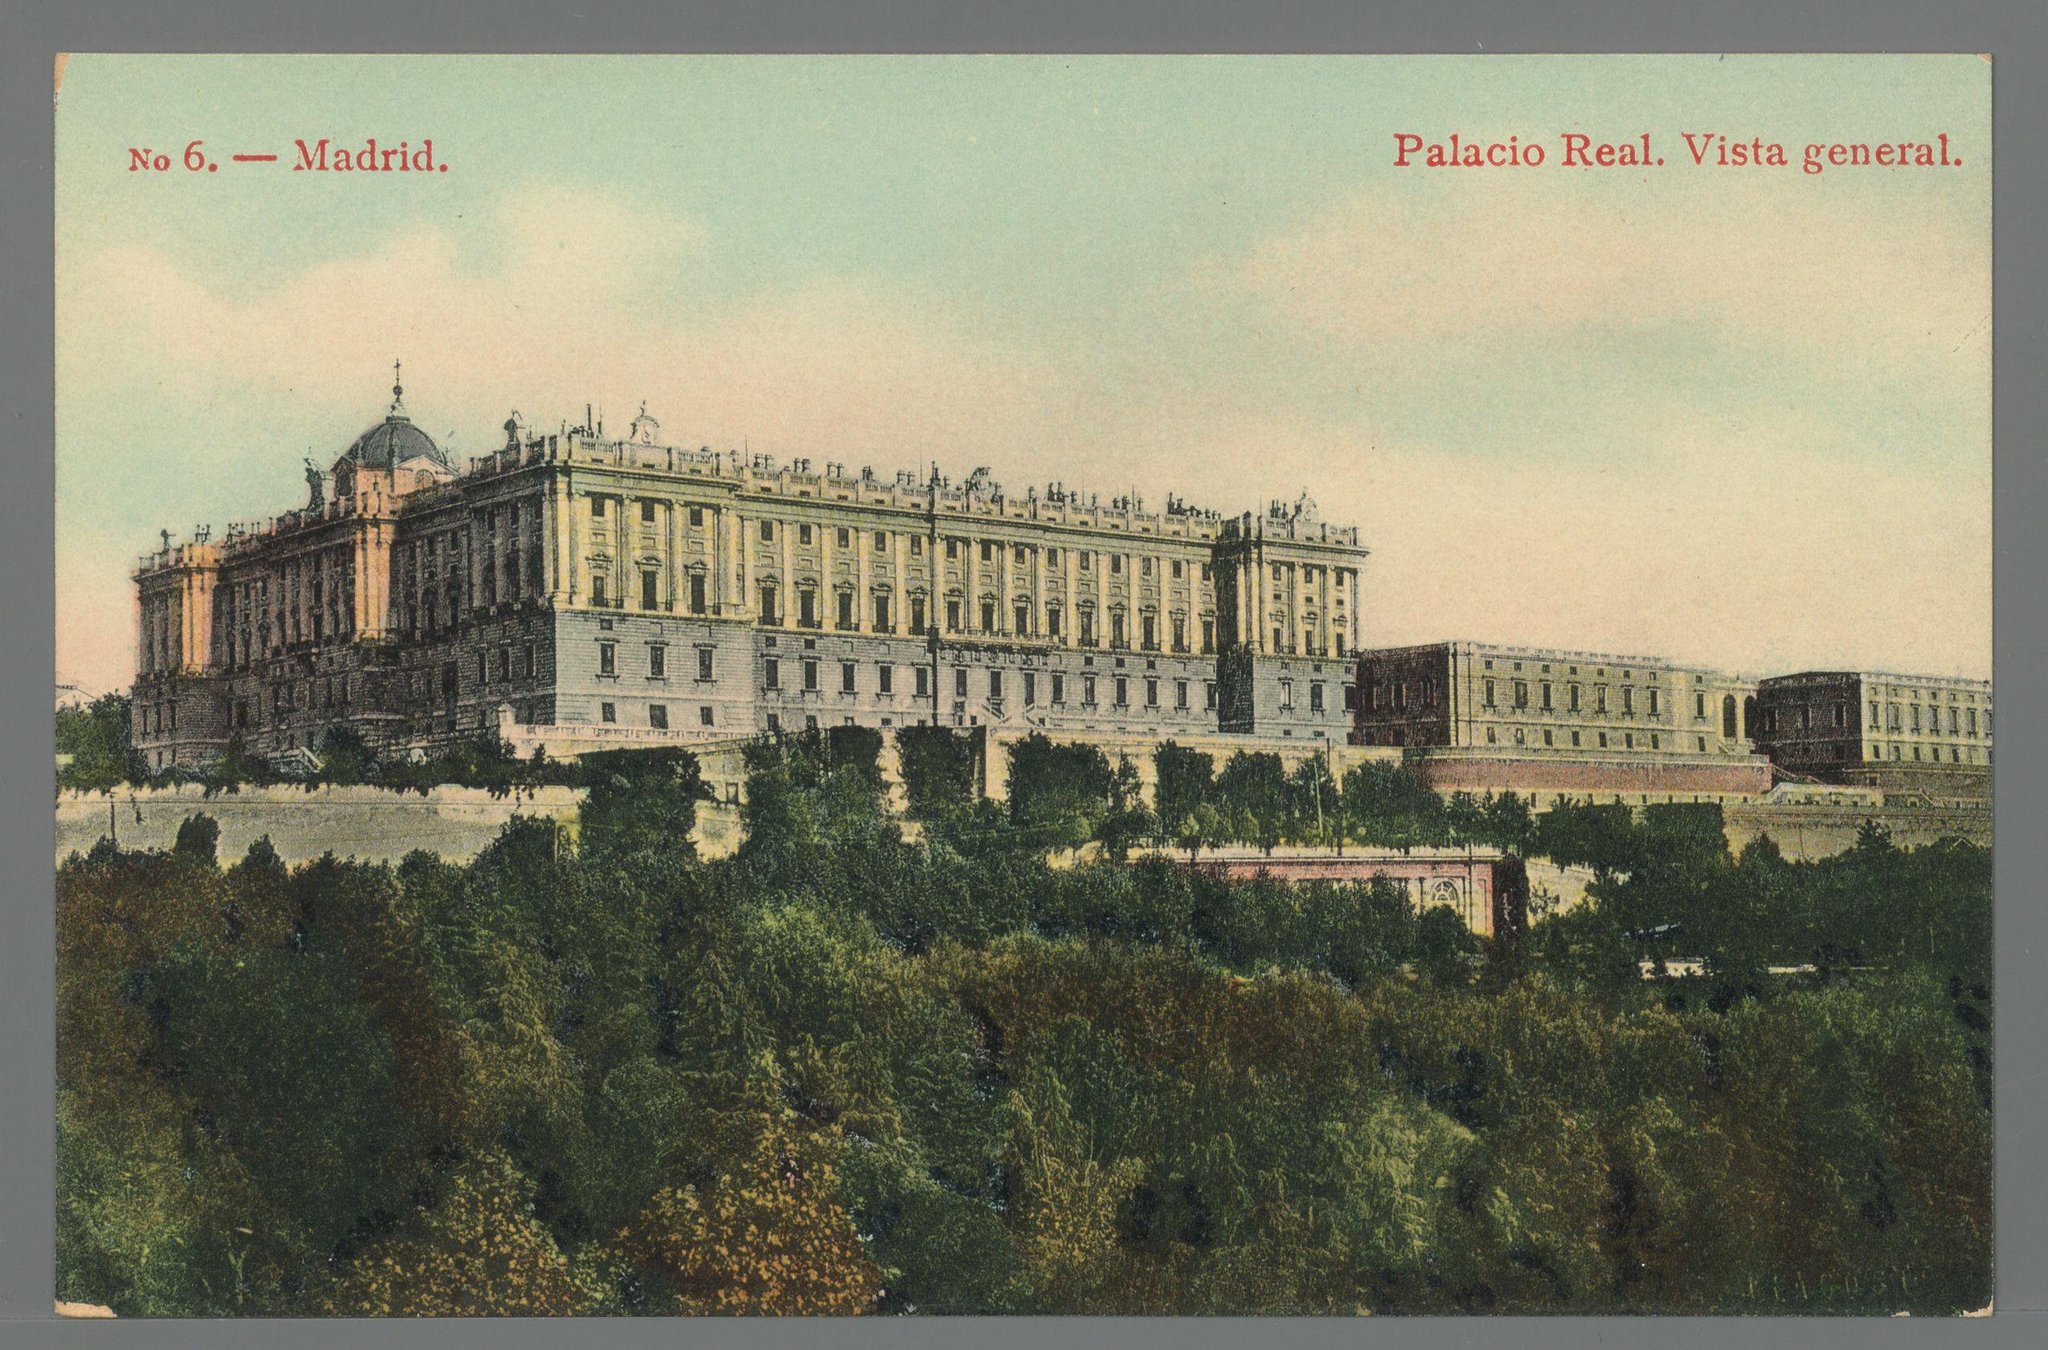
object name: ansichtkaart, prentbriefkaart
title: Madrid. Palacio Real. Vista general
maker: Anonymous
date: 1906-1930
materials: cardboard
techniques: photograph, lithograph, writing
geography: madrid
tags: palace